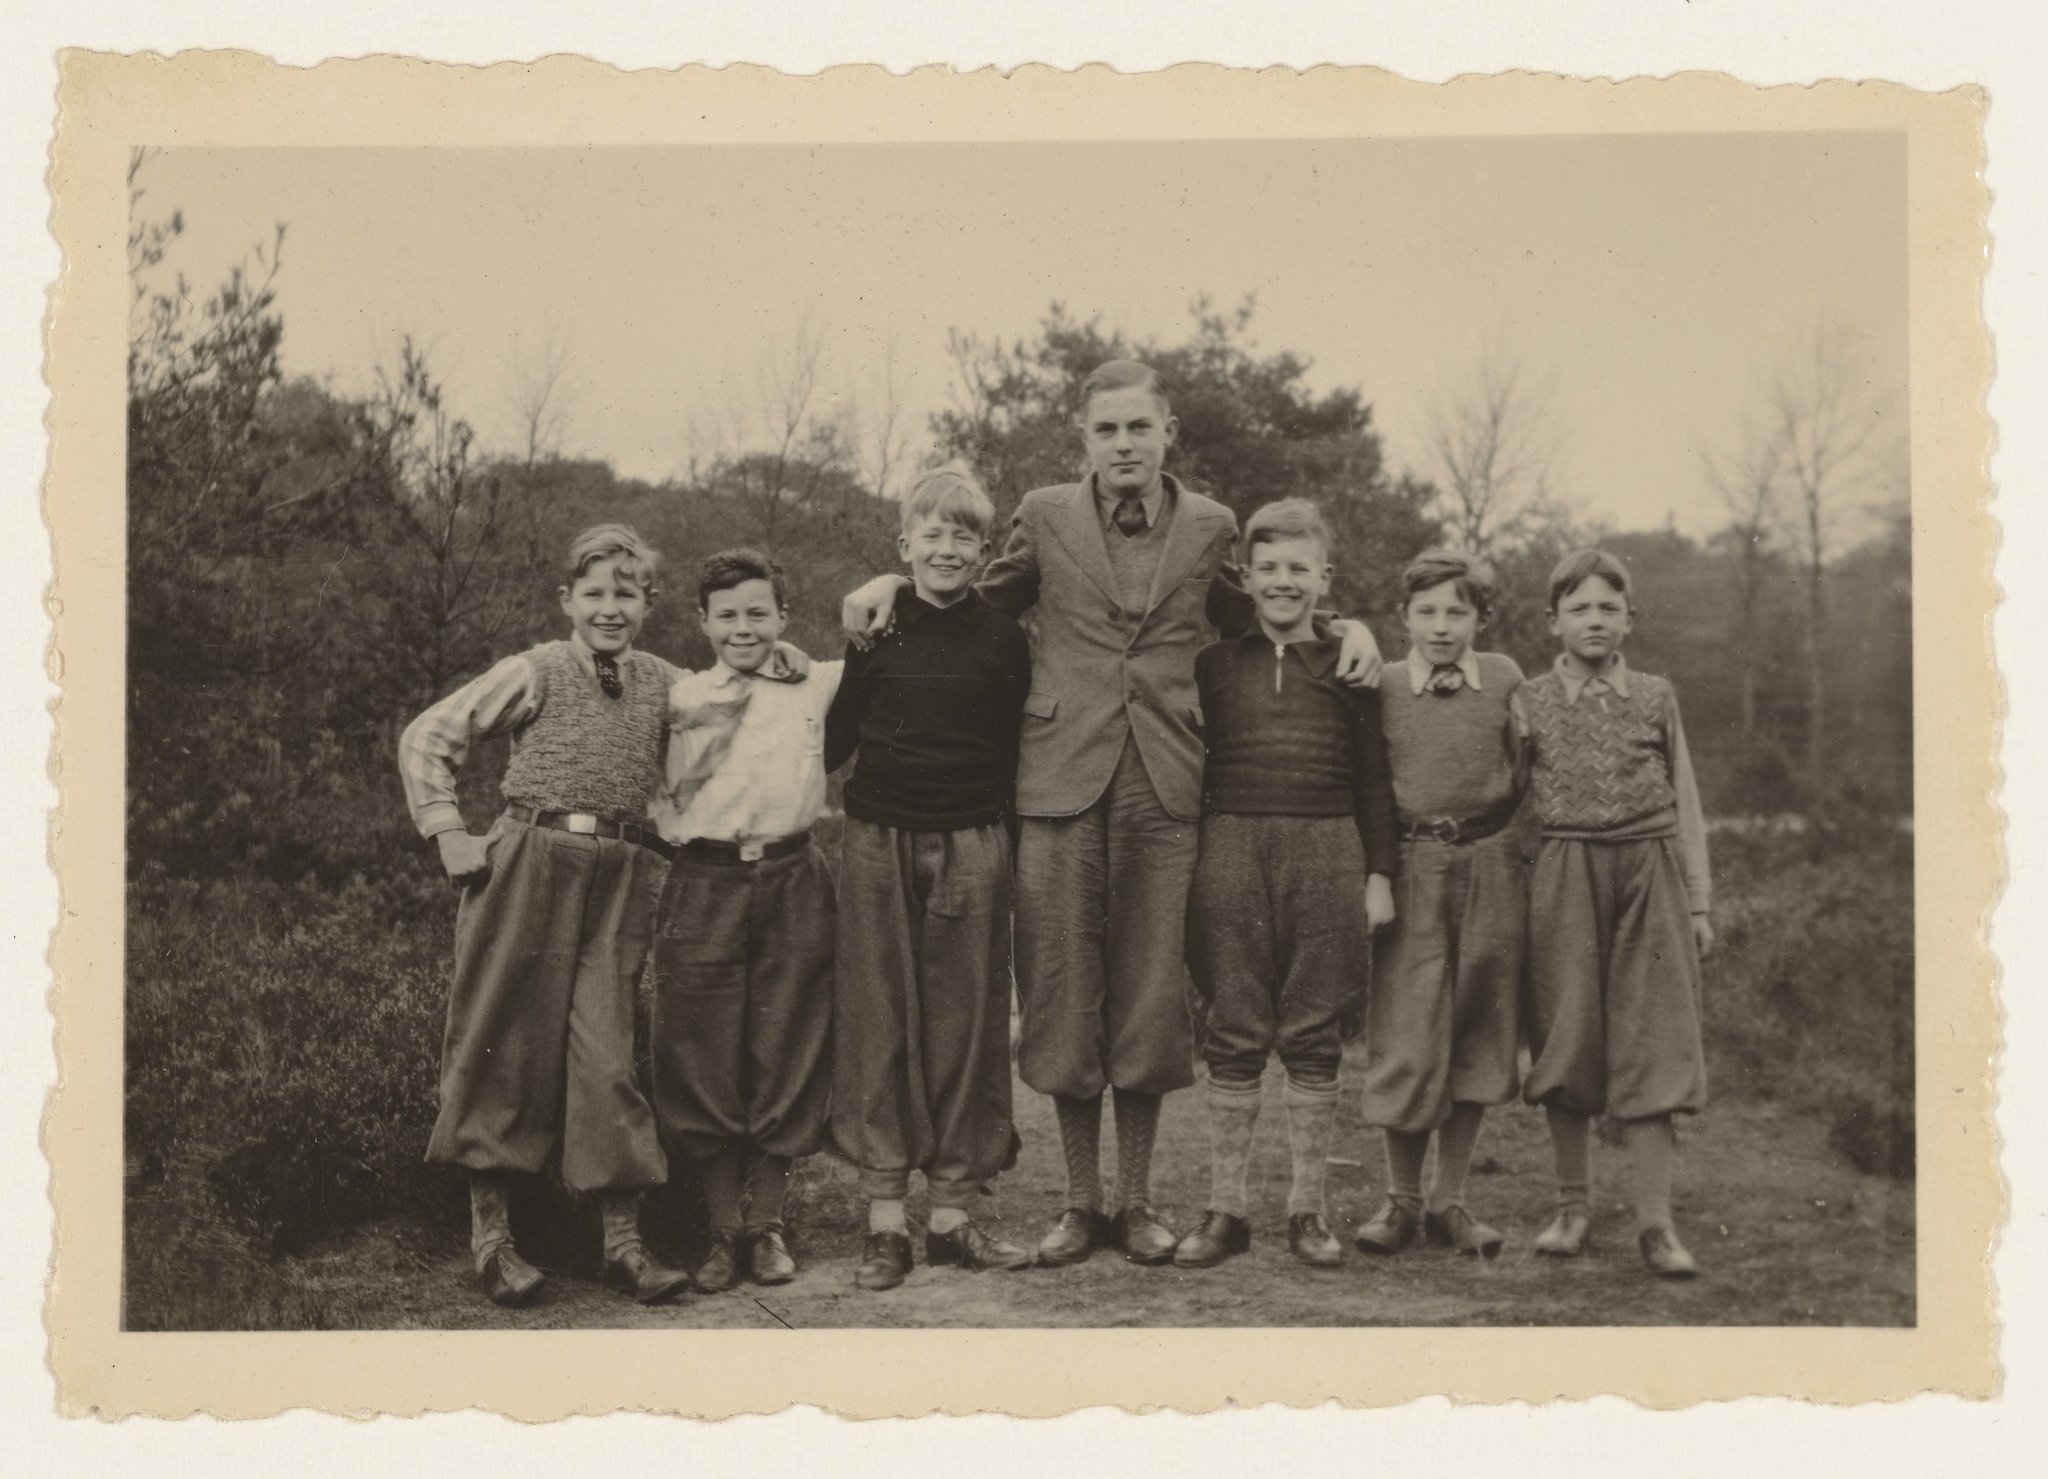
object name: photograph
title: Jeugdstorm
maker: Anonymous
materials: photographic support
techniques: photography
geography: netherlands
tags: netherlands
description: Jongens van de Jeugdstorm? niet in uniform maar allen in plusfour poseren buiten voor de fotograaf.